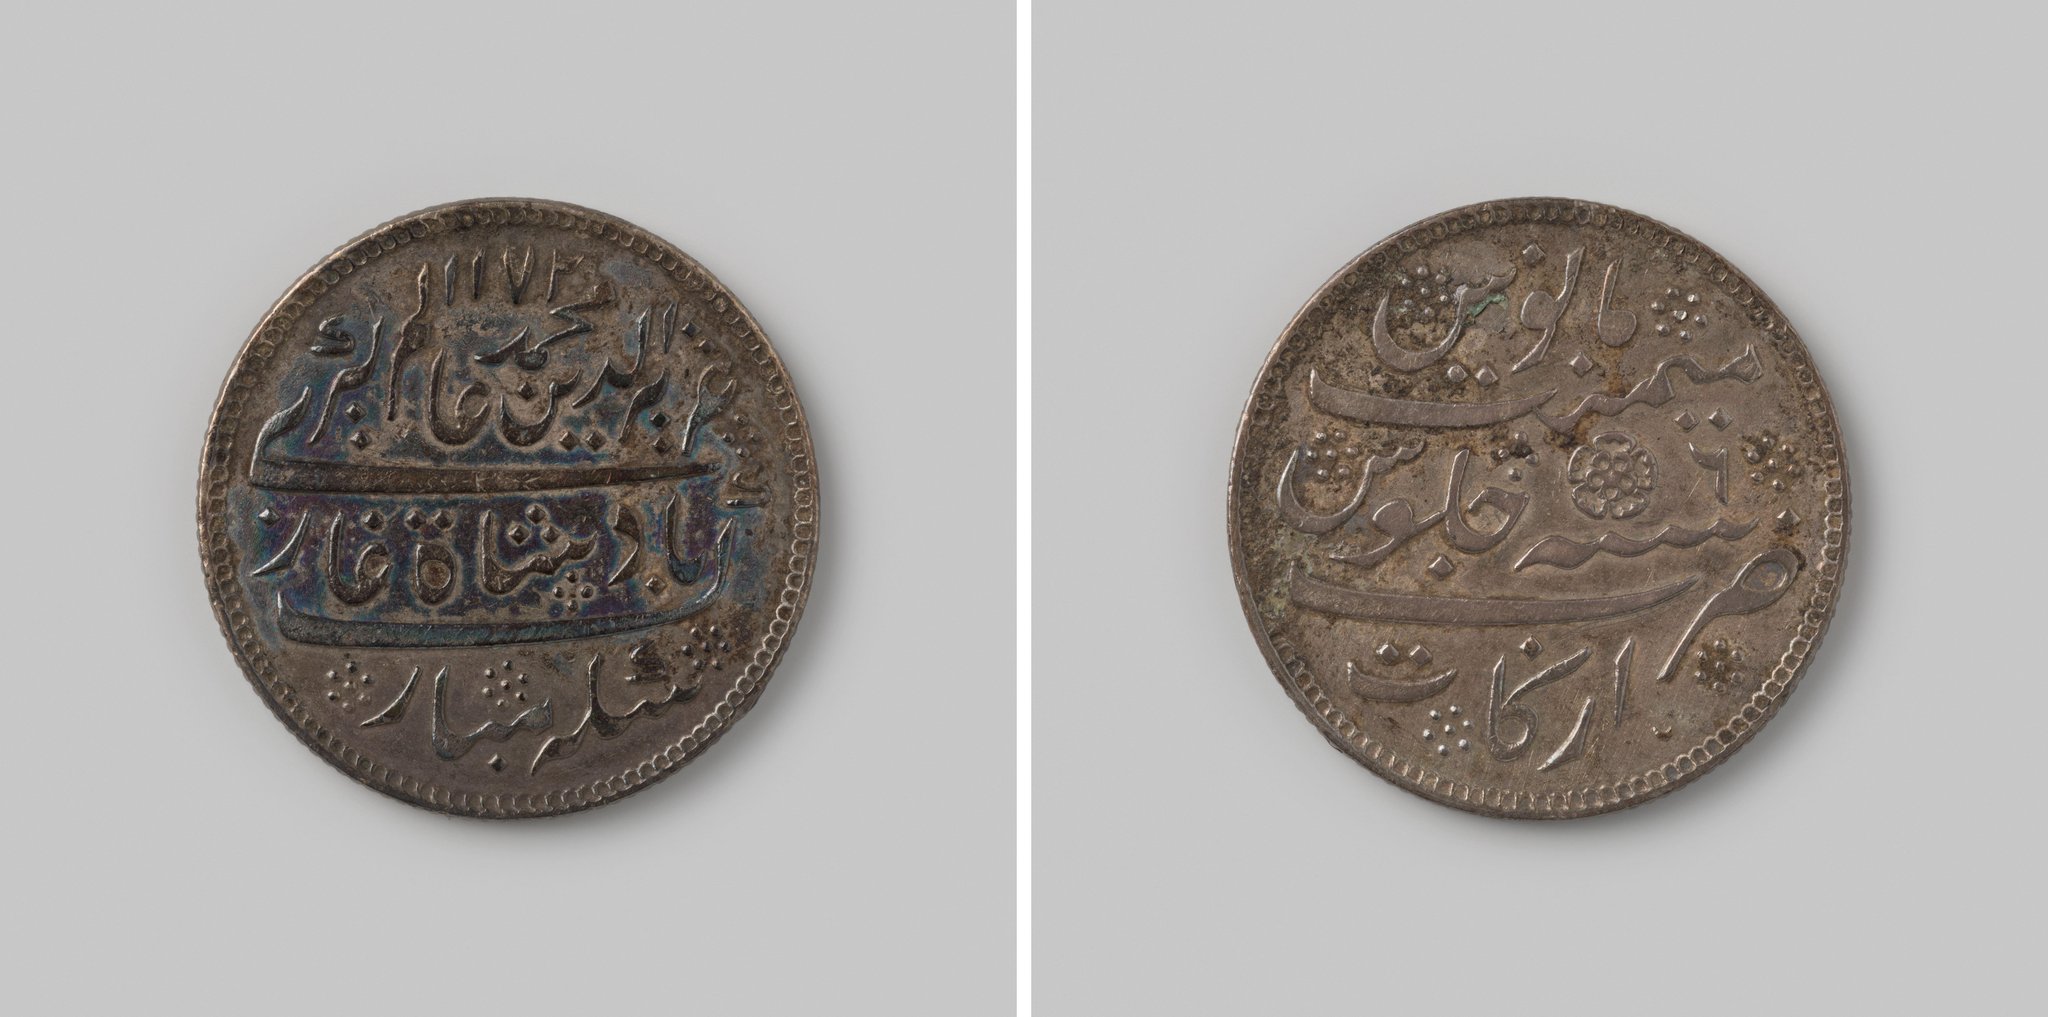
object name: coin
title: India, Engelse Oostindische Compagnie (EIC) , arcot-roepie voor Madras, India, op naam van shah Alamgir II, (1823-1825)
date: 1823-1825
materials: silver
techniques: striking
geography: kolkata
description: Zilveren munt. Voorzijde: opschrift in drie regels in Arabische lettertekens, waarin verwijzing naar shah Alamgir II. Links boven "bevroren" jaartal: 1172. Keerzijde: opschrift in drie regels in Arabische lettertekens. rechts aanduiding regeringsjaar: 6 en daarnaast rozet [=muntplaats Calcutta]. Kartelrand.